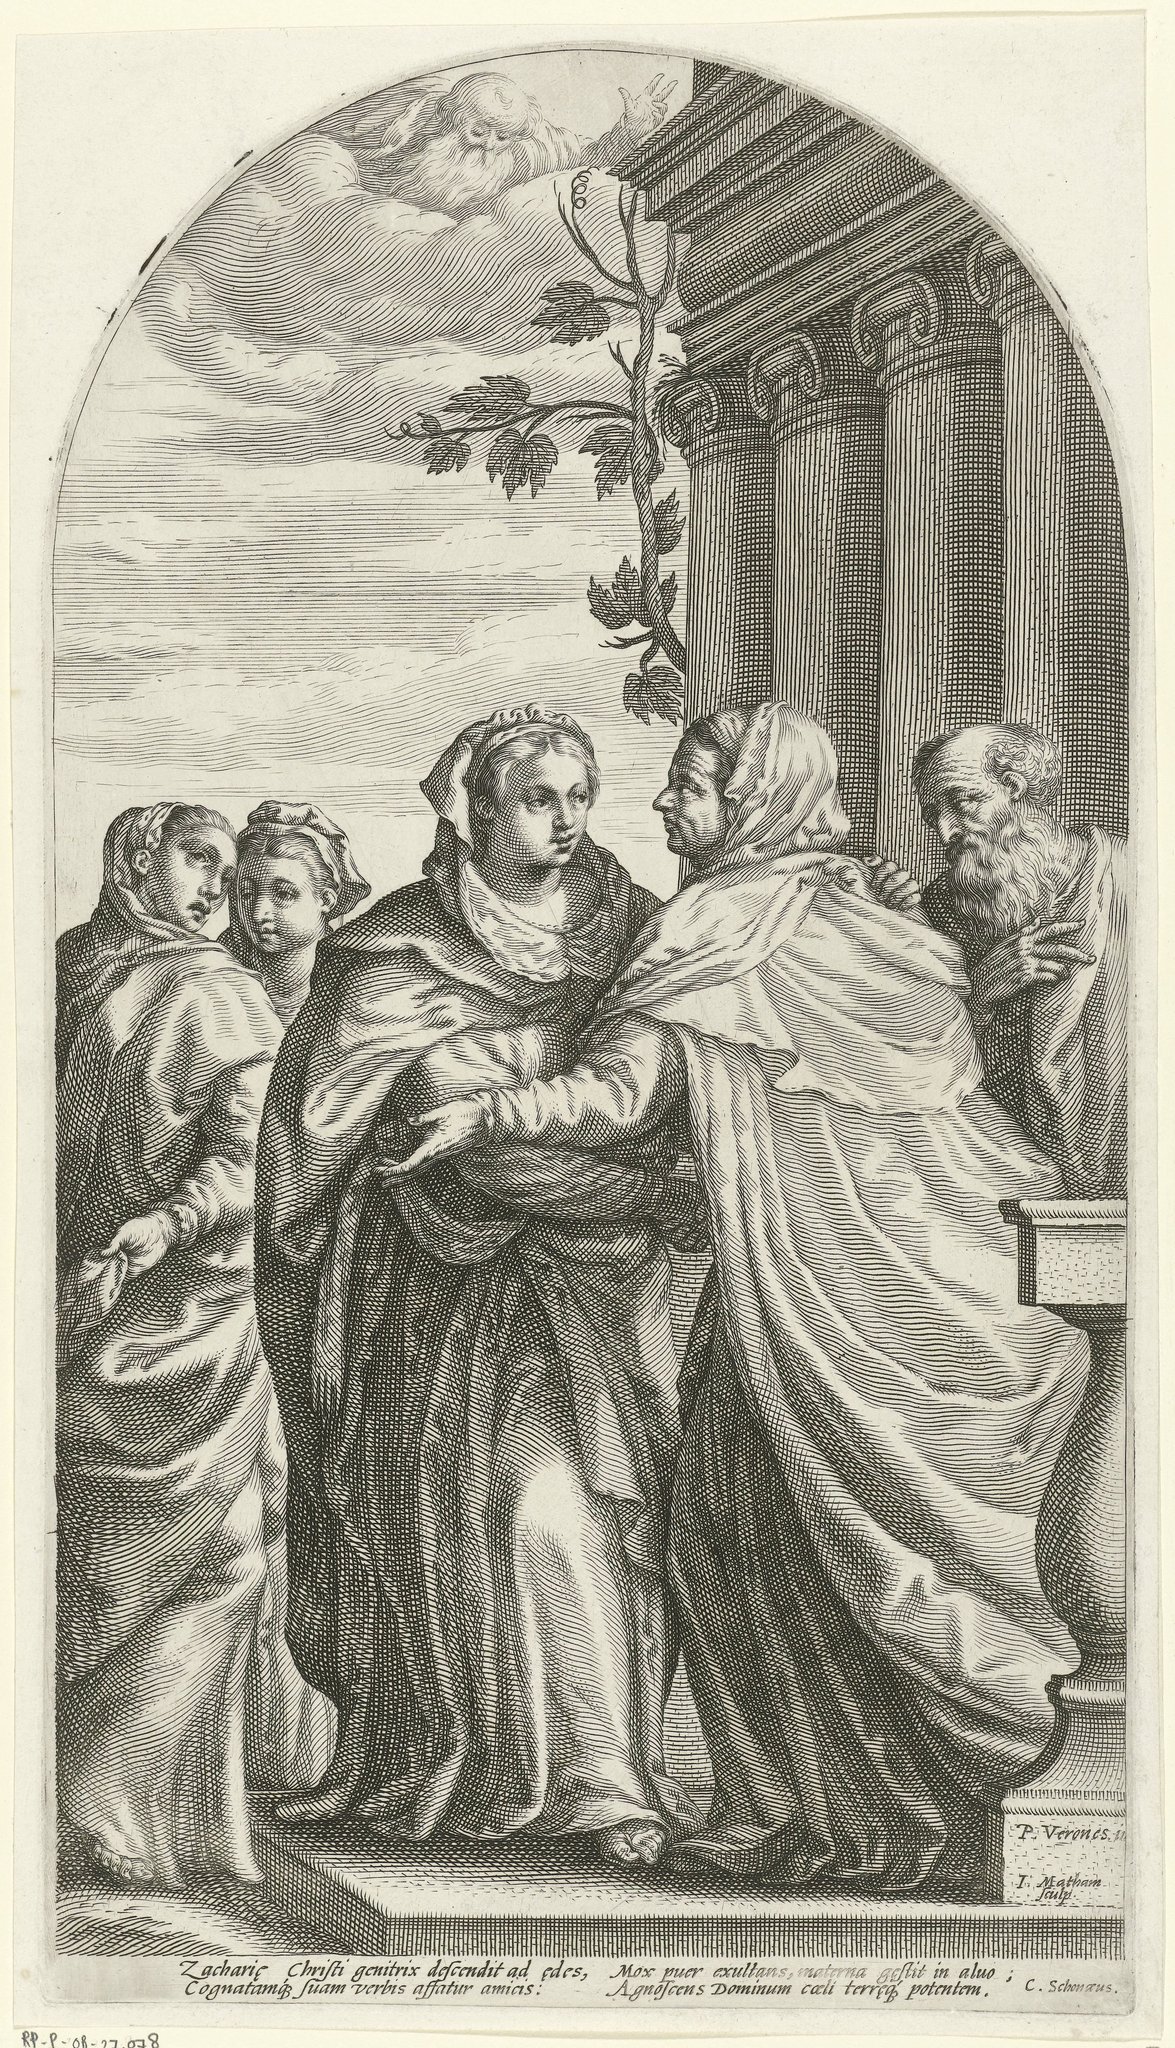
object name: print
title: Visitatie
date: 1592-1596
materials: paper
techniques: engraving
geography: haarlem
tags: mary and elisabeth shaking hands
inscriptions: collector's mark: Lugt 240